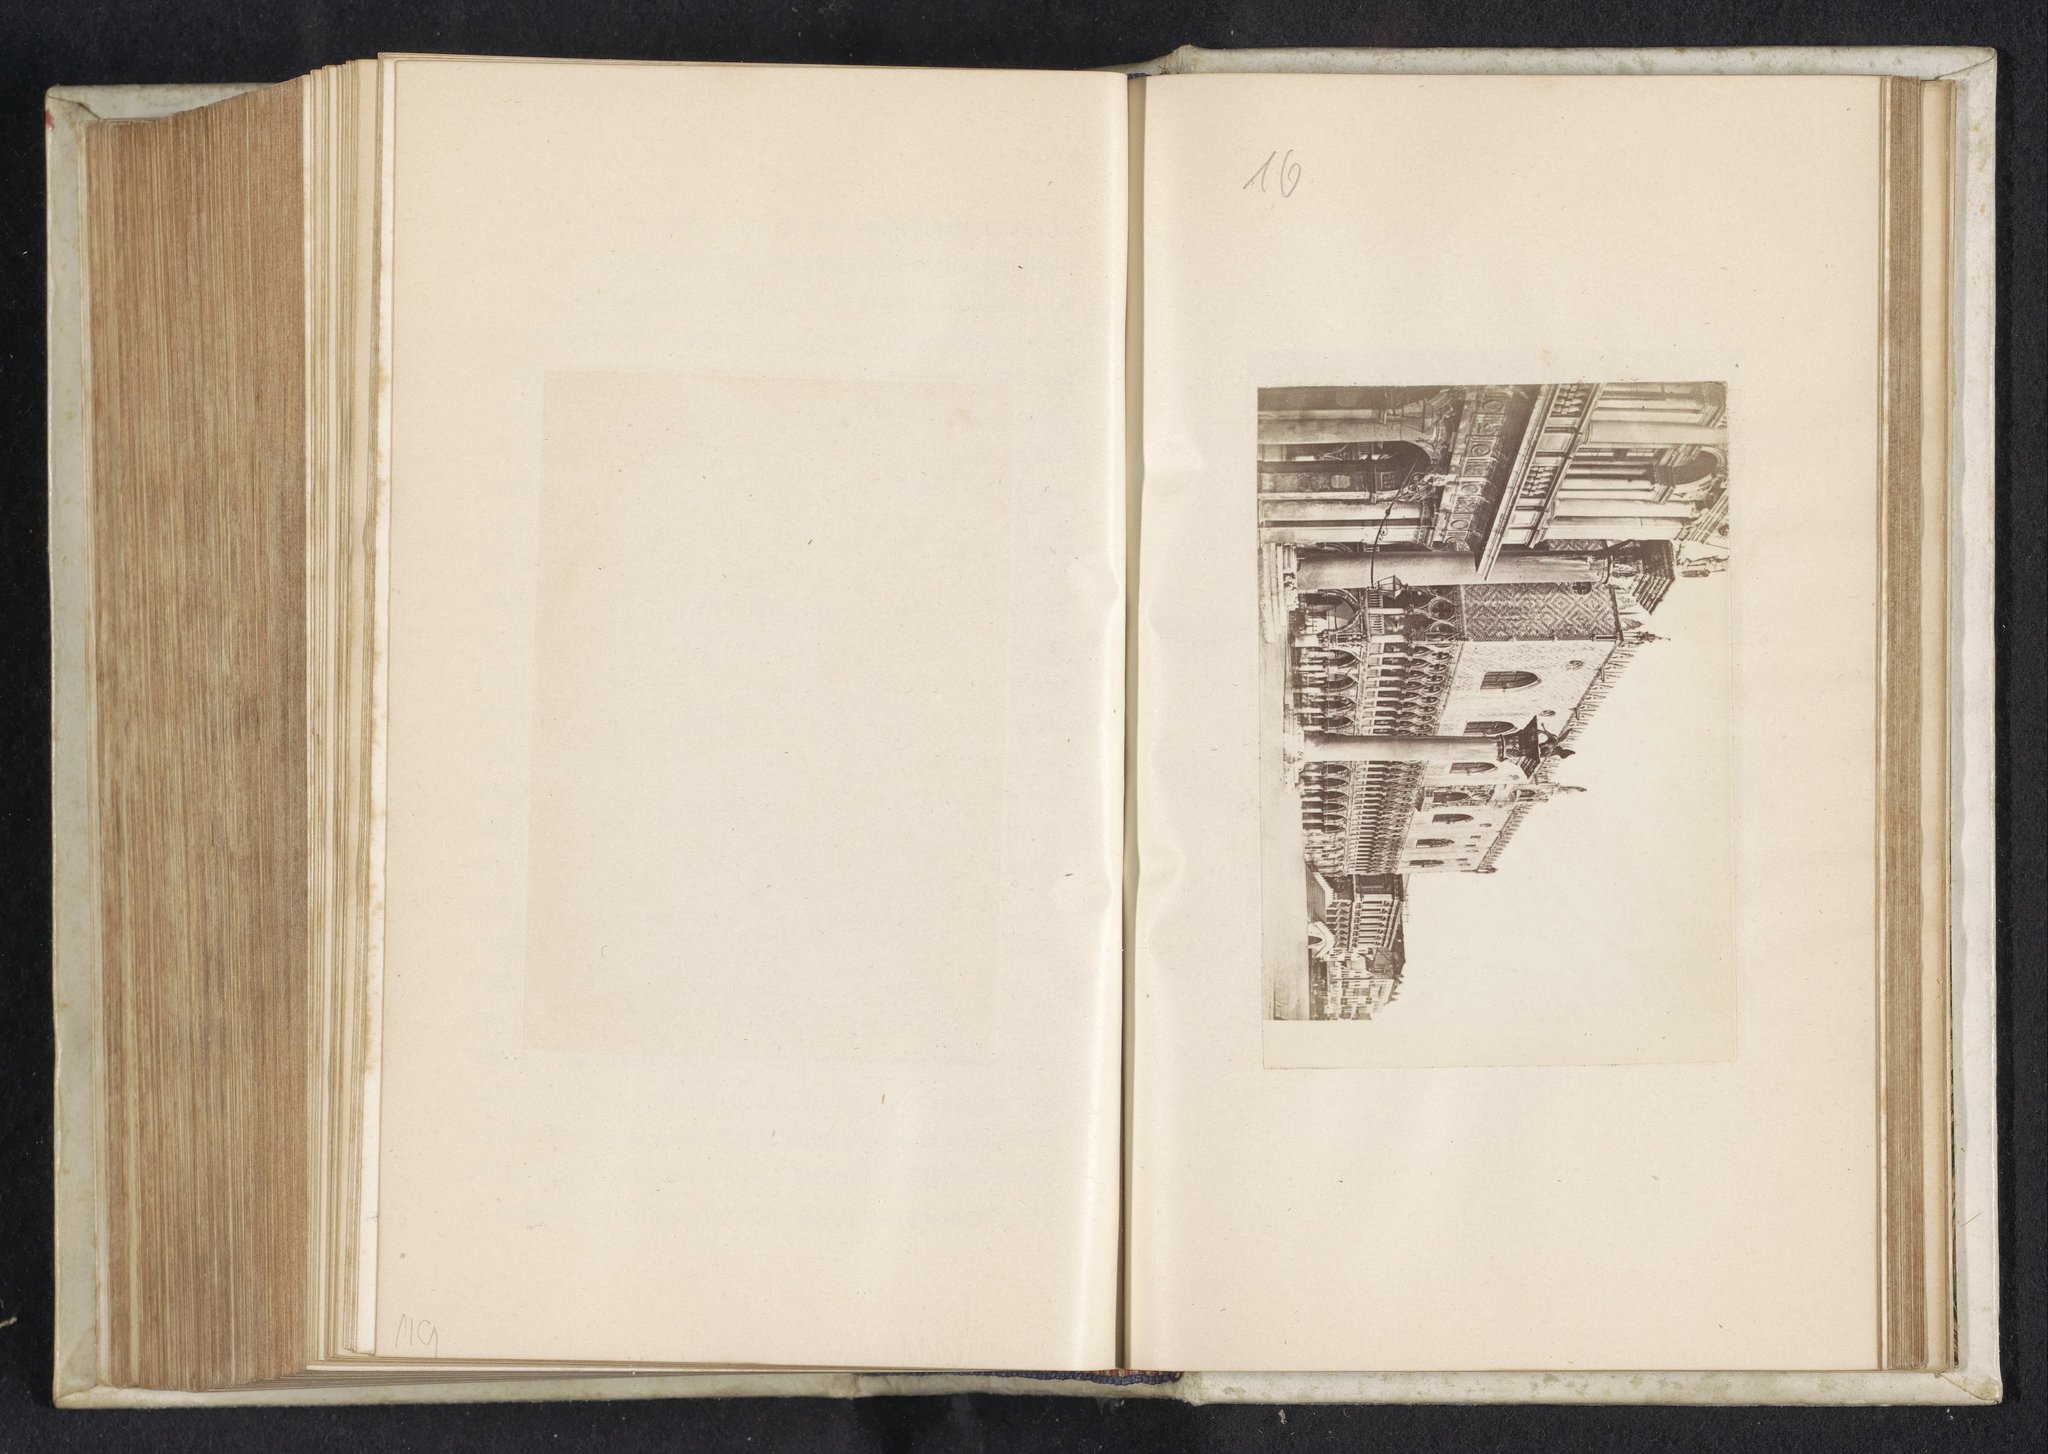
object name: photograph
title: Exterieur van het Dogepaleis te Venetië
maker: Anonymous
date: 1850-1860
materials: photographic support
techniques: albumen print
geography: san marco square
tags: palace, façade (of house or building)